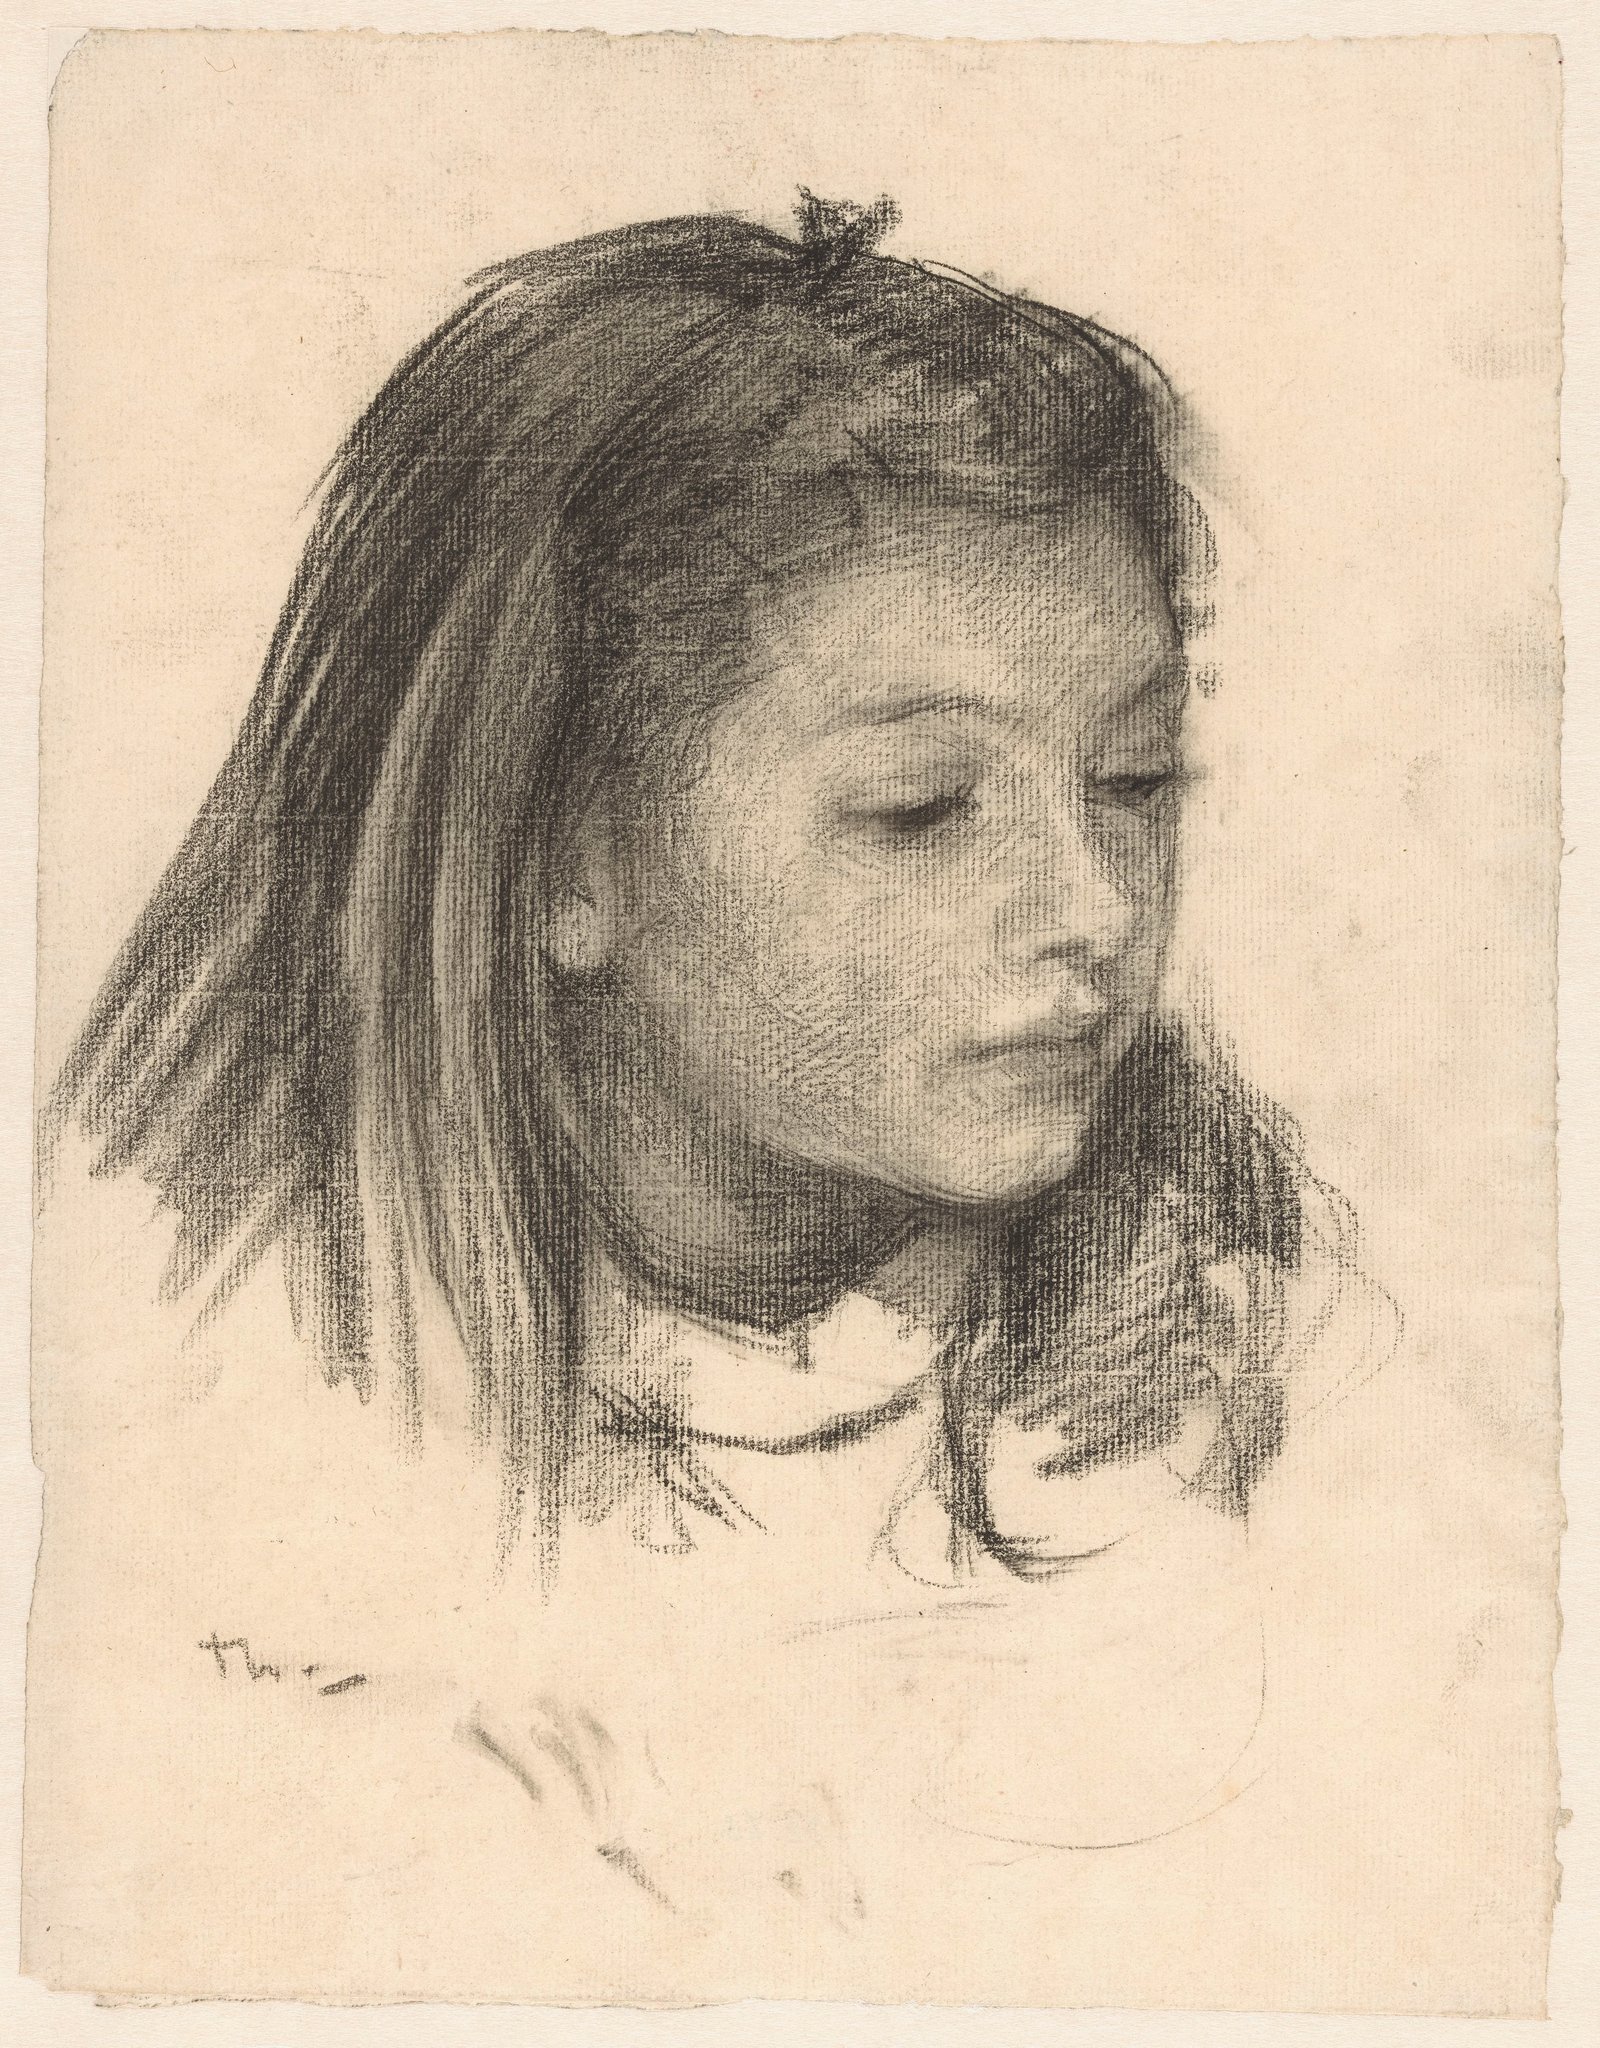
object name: drawing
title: Portret van een meisje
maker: willem bastiaan tholen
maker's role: draughtsman, painter, print maker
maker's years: 1860-1931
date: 1870-1931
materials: chalk, paper